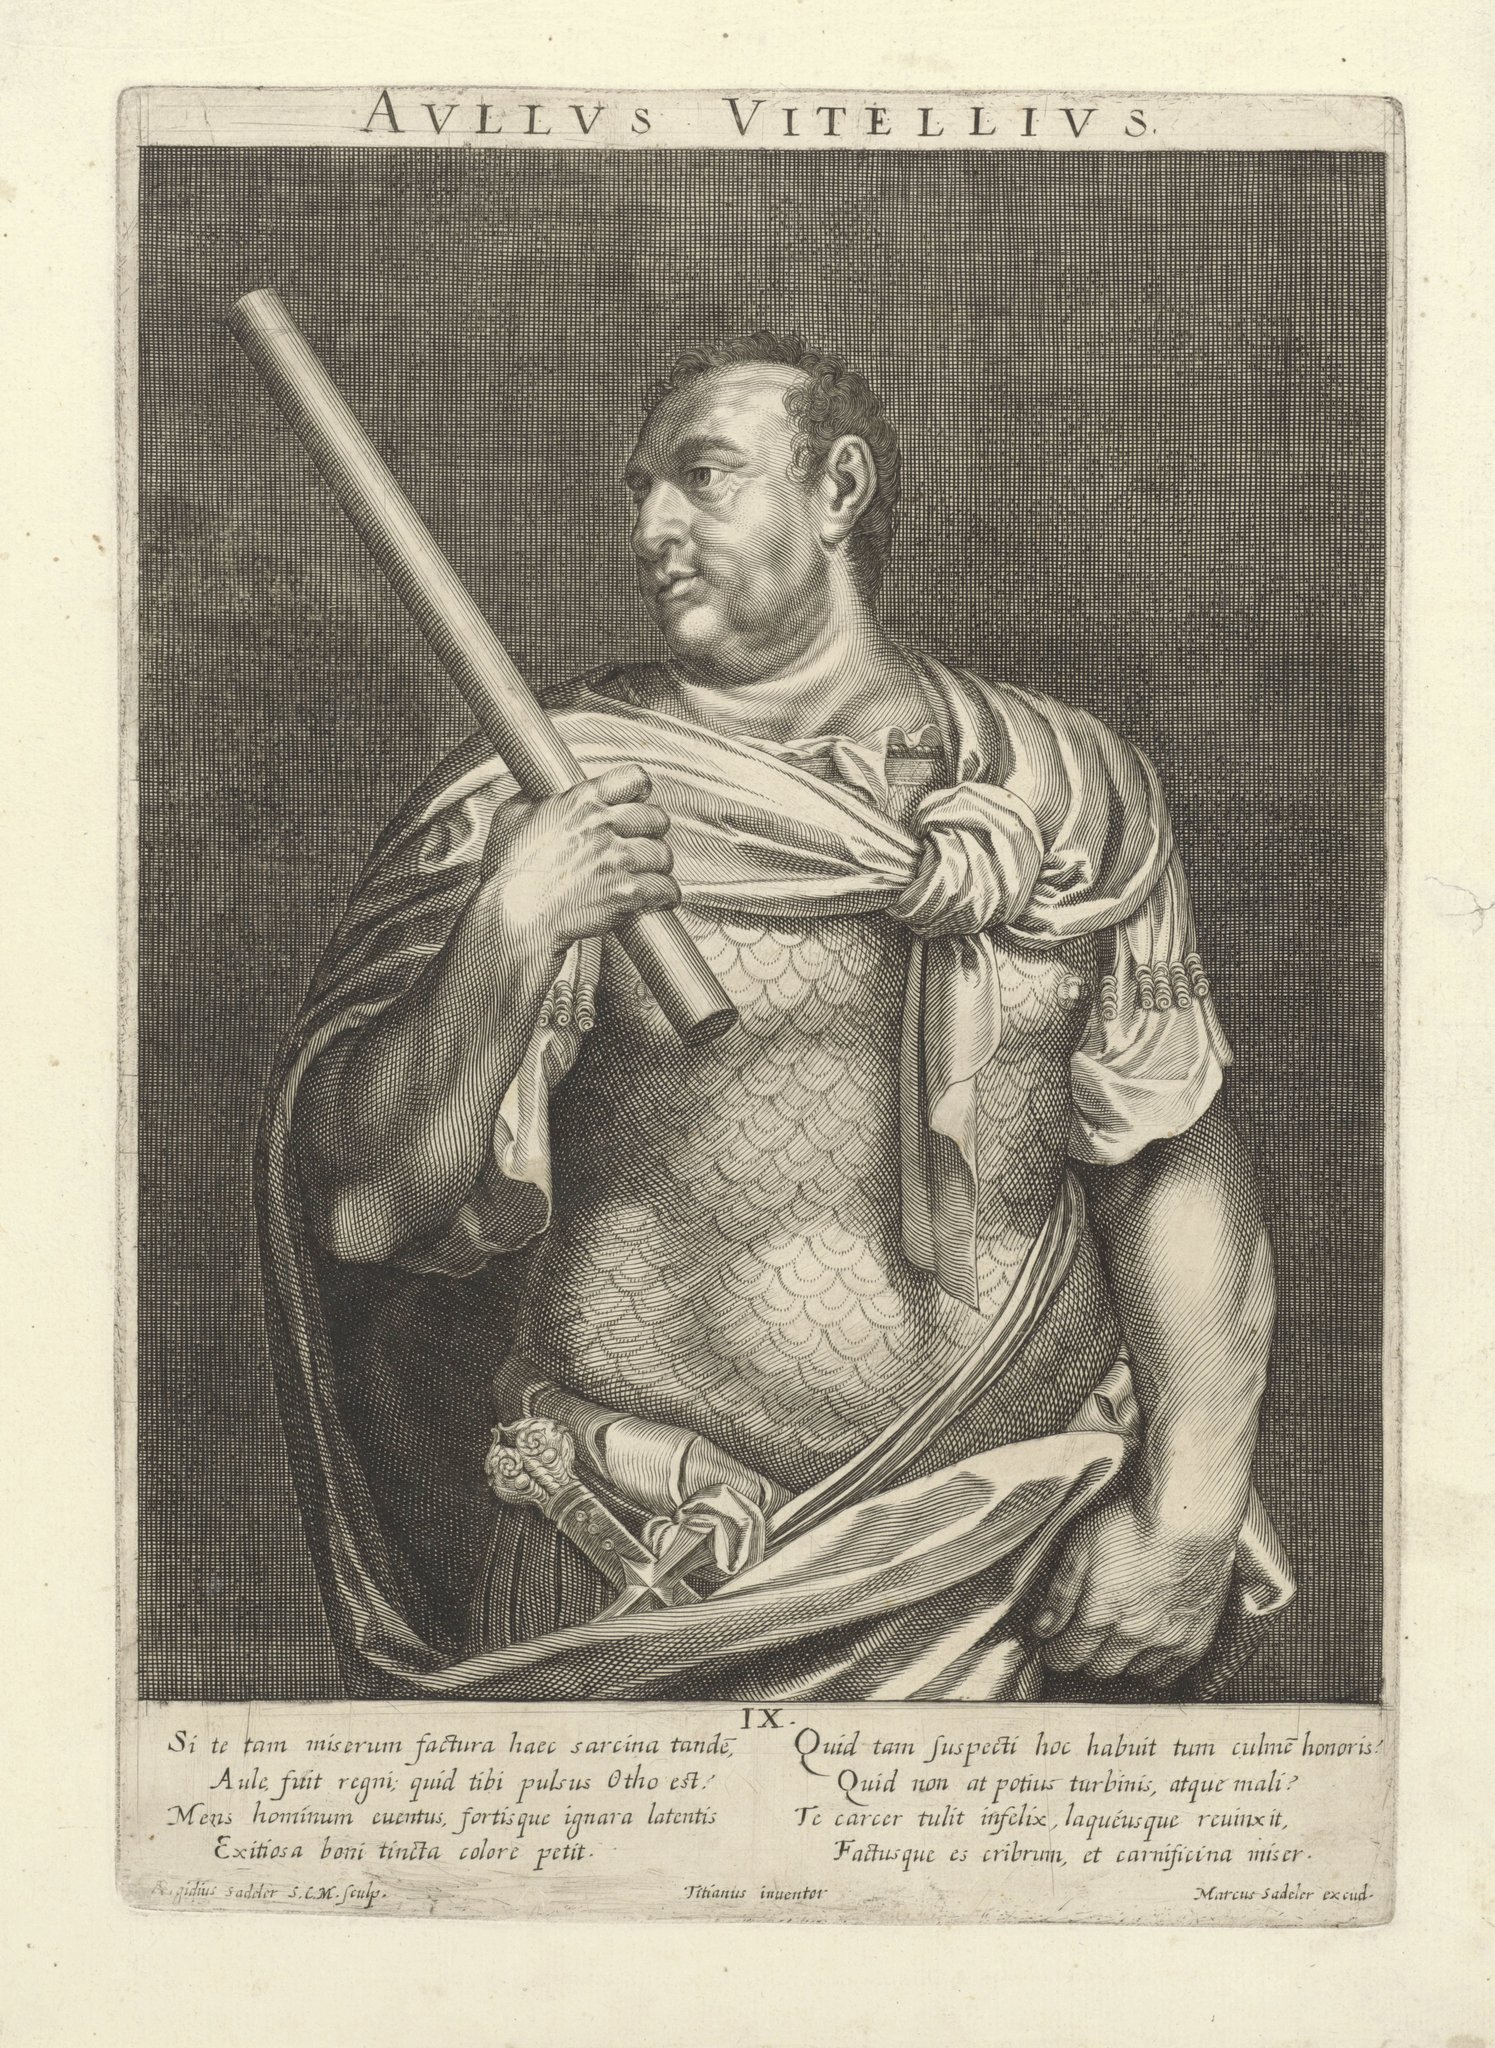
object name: print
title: Romeinse keizers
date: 1597-1629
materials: paper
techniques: engraving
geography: prague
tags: rome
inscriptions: collector's mark: Lugt 240